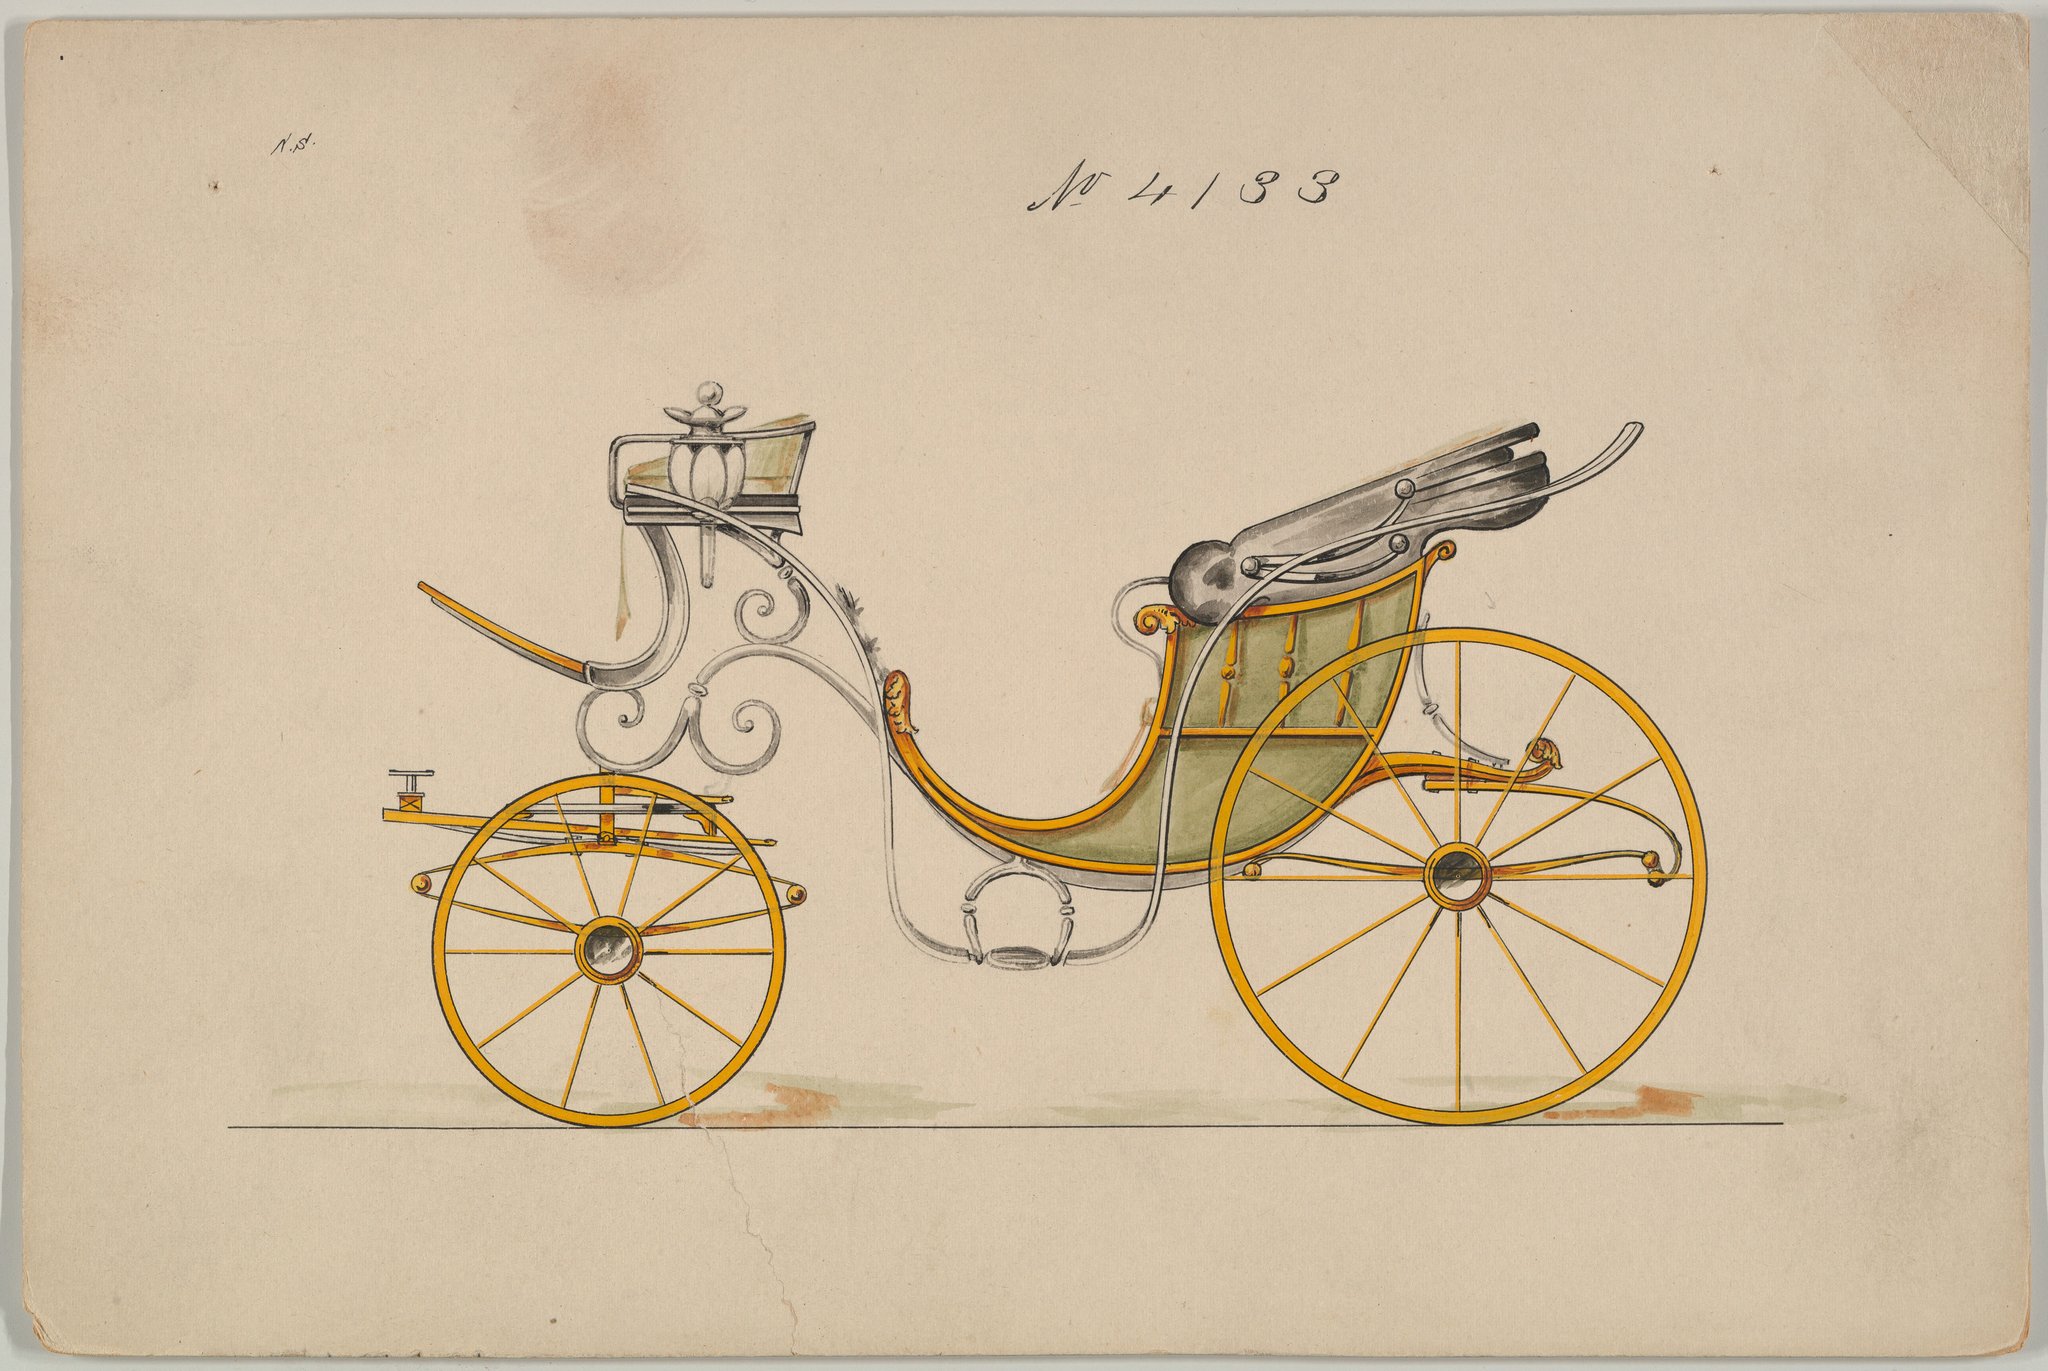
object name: drawing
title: Design for Cabriolet or Victoria, no. 4133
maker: brewster & co.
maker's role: manufacturer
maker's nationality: american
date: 1891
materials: gouache, ink, watercolor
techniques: pen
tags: carriages